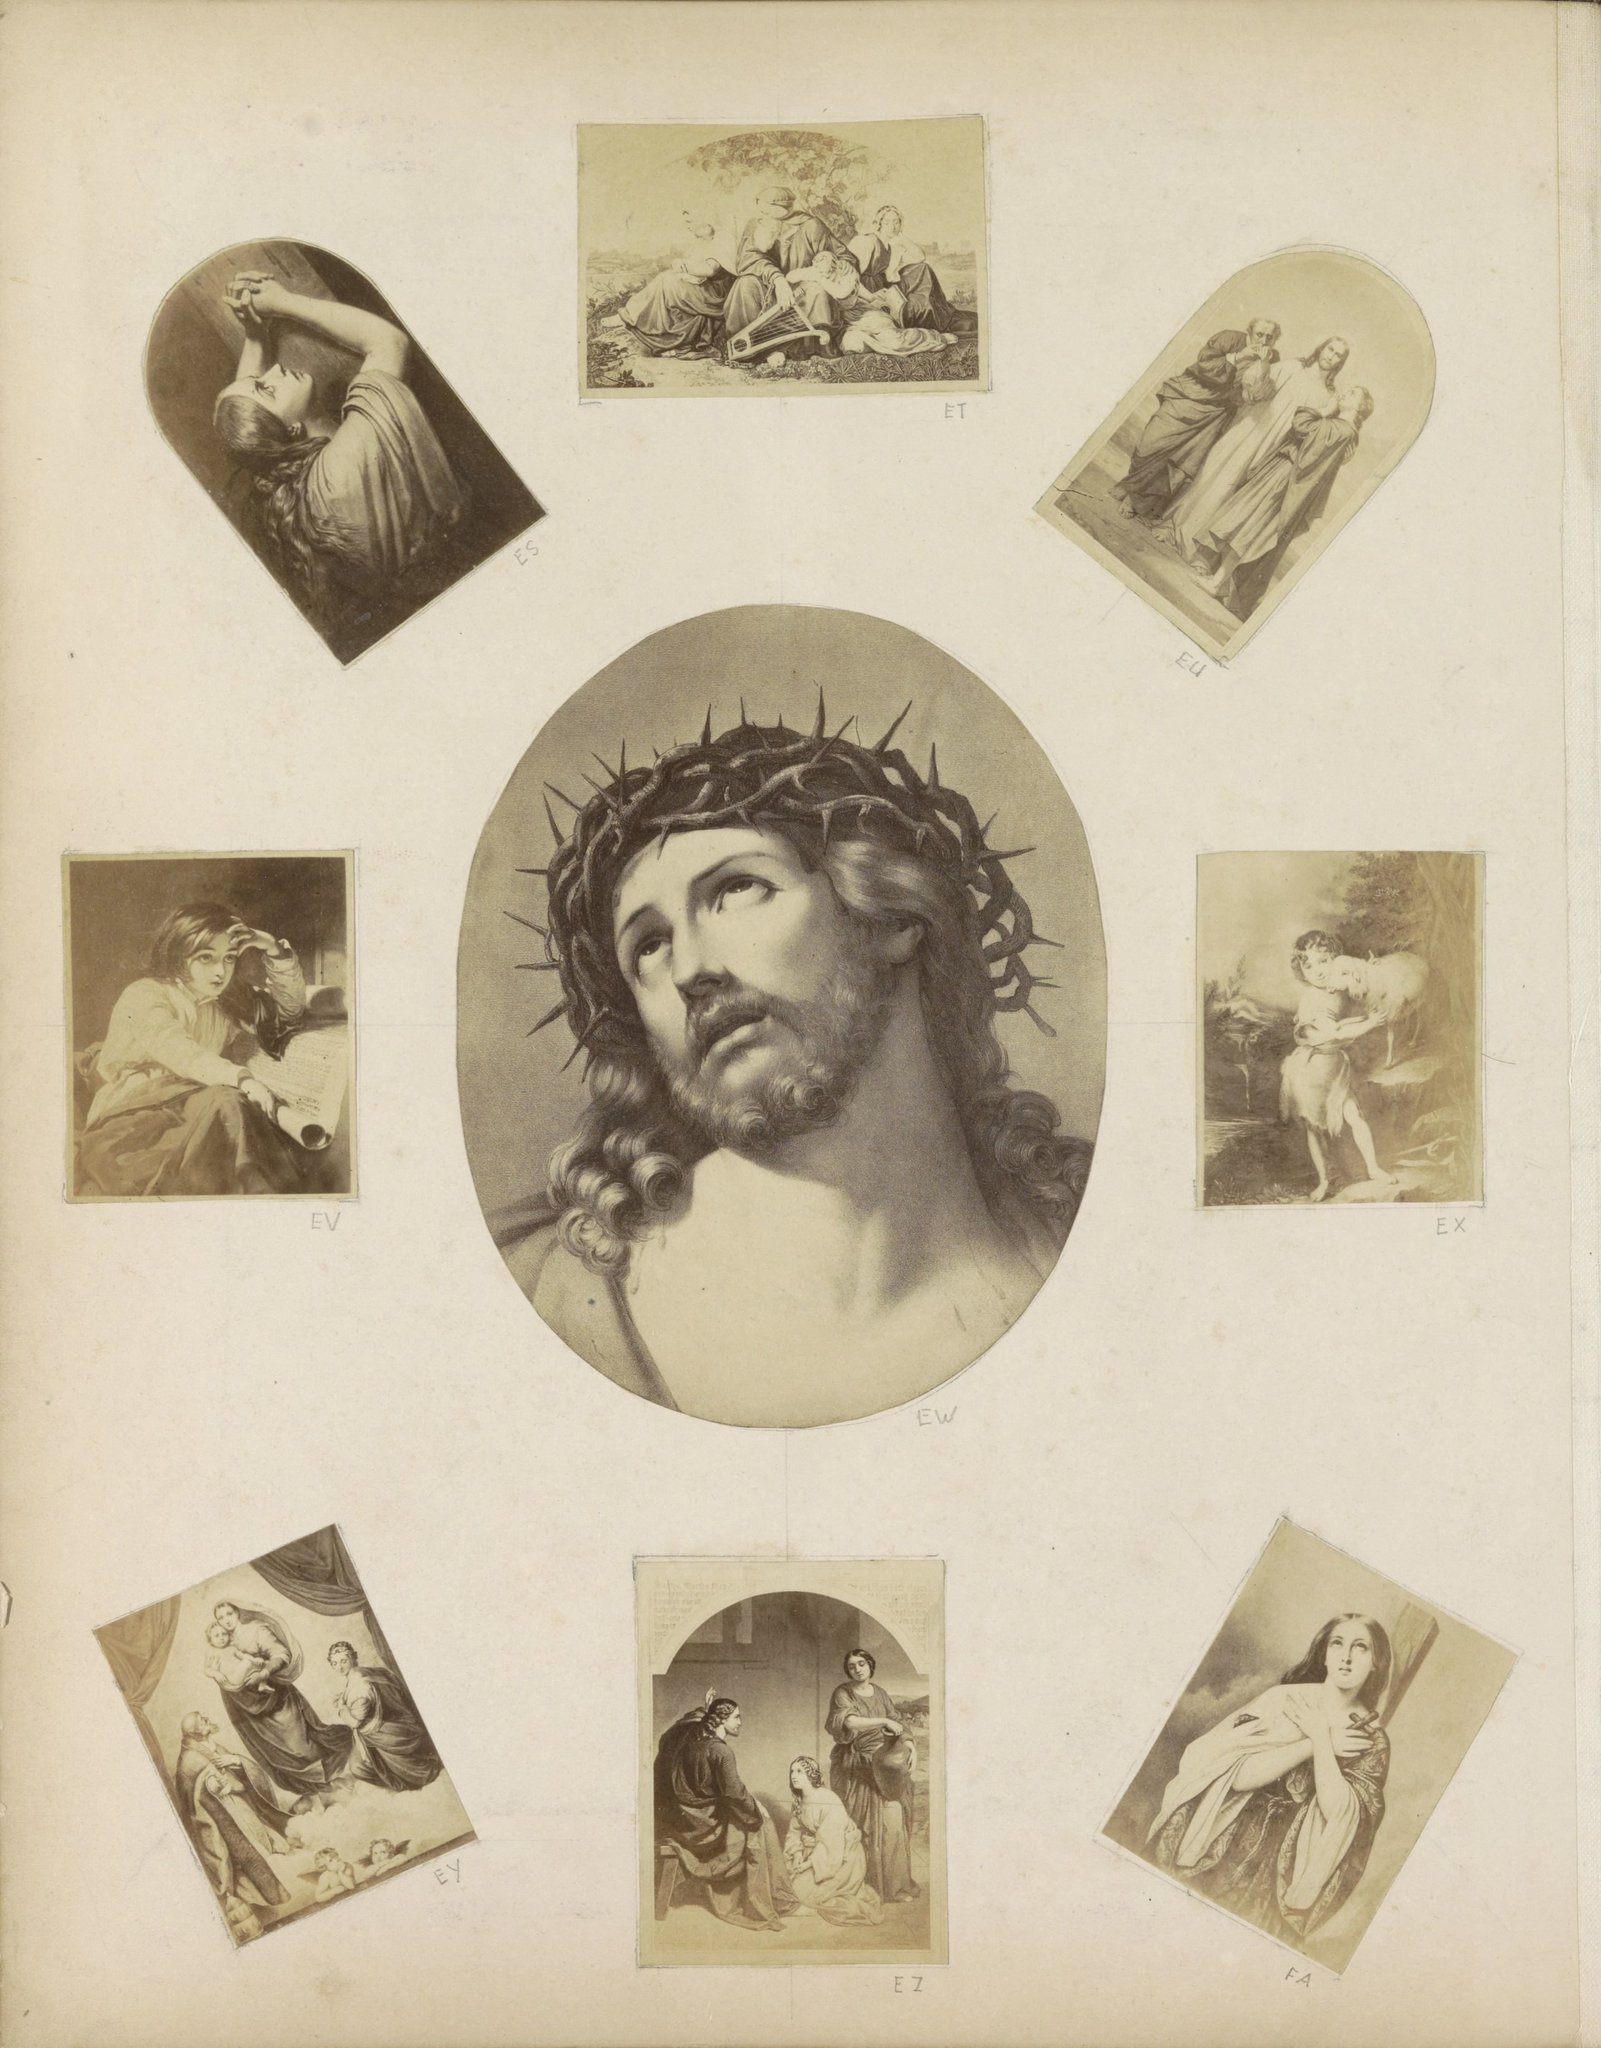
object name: photograph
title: Fotoreproductie van (vermoedelijk) een prent van een bijbels tafereel met een geketende man met een lier omringd door vrouwen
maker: Anonymous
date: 1850-1870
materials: paper, photographic support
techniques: albumen print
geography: england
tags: lyre, cithara, psaltery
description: Onderdeel van Album met foto's van bezienswaardigheden en landschappen in Engeland en van kunst.